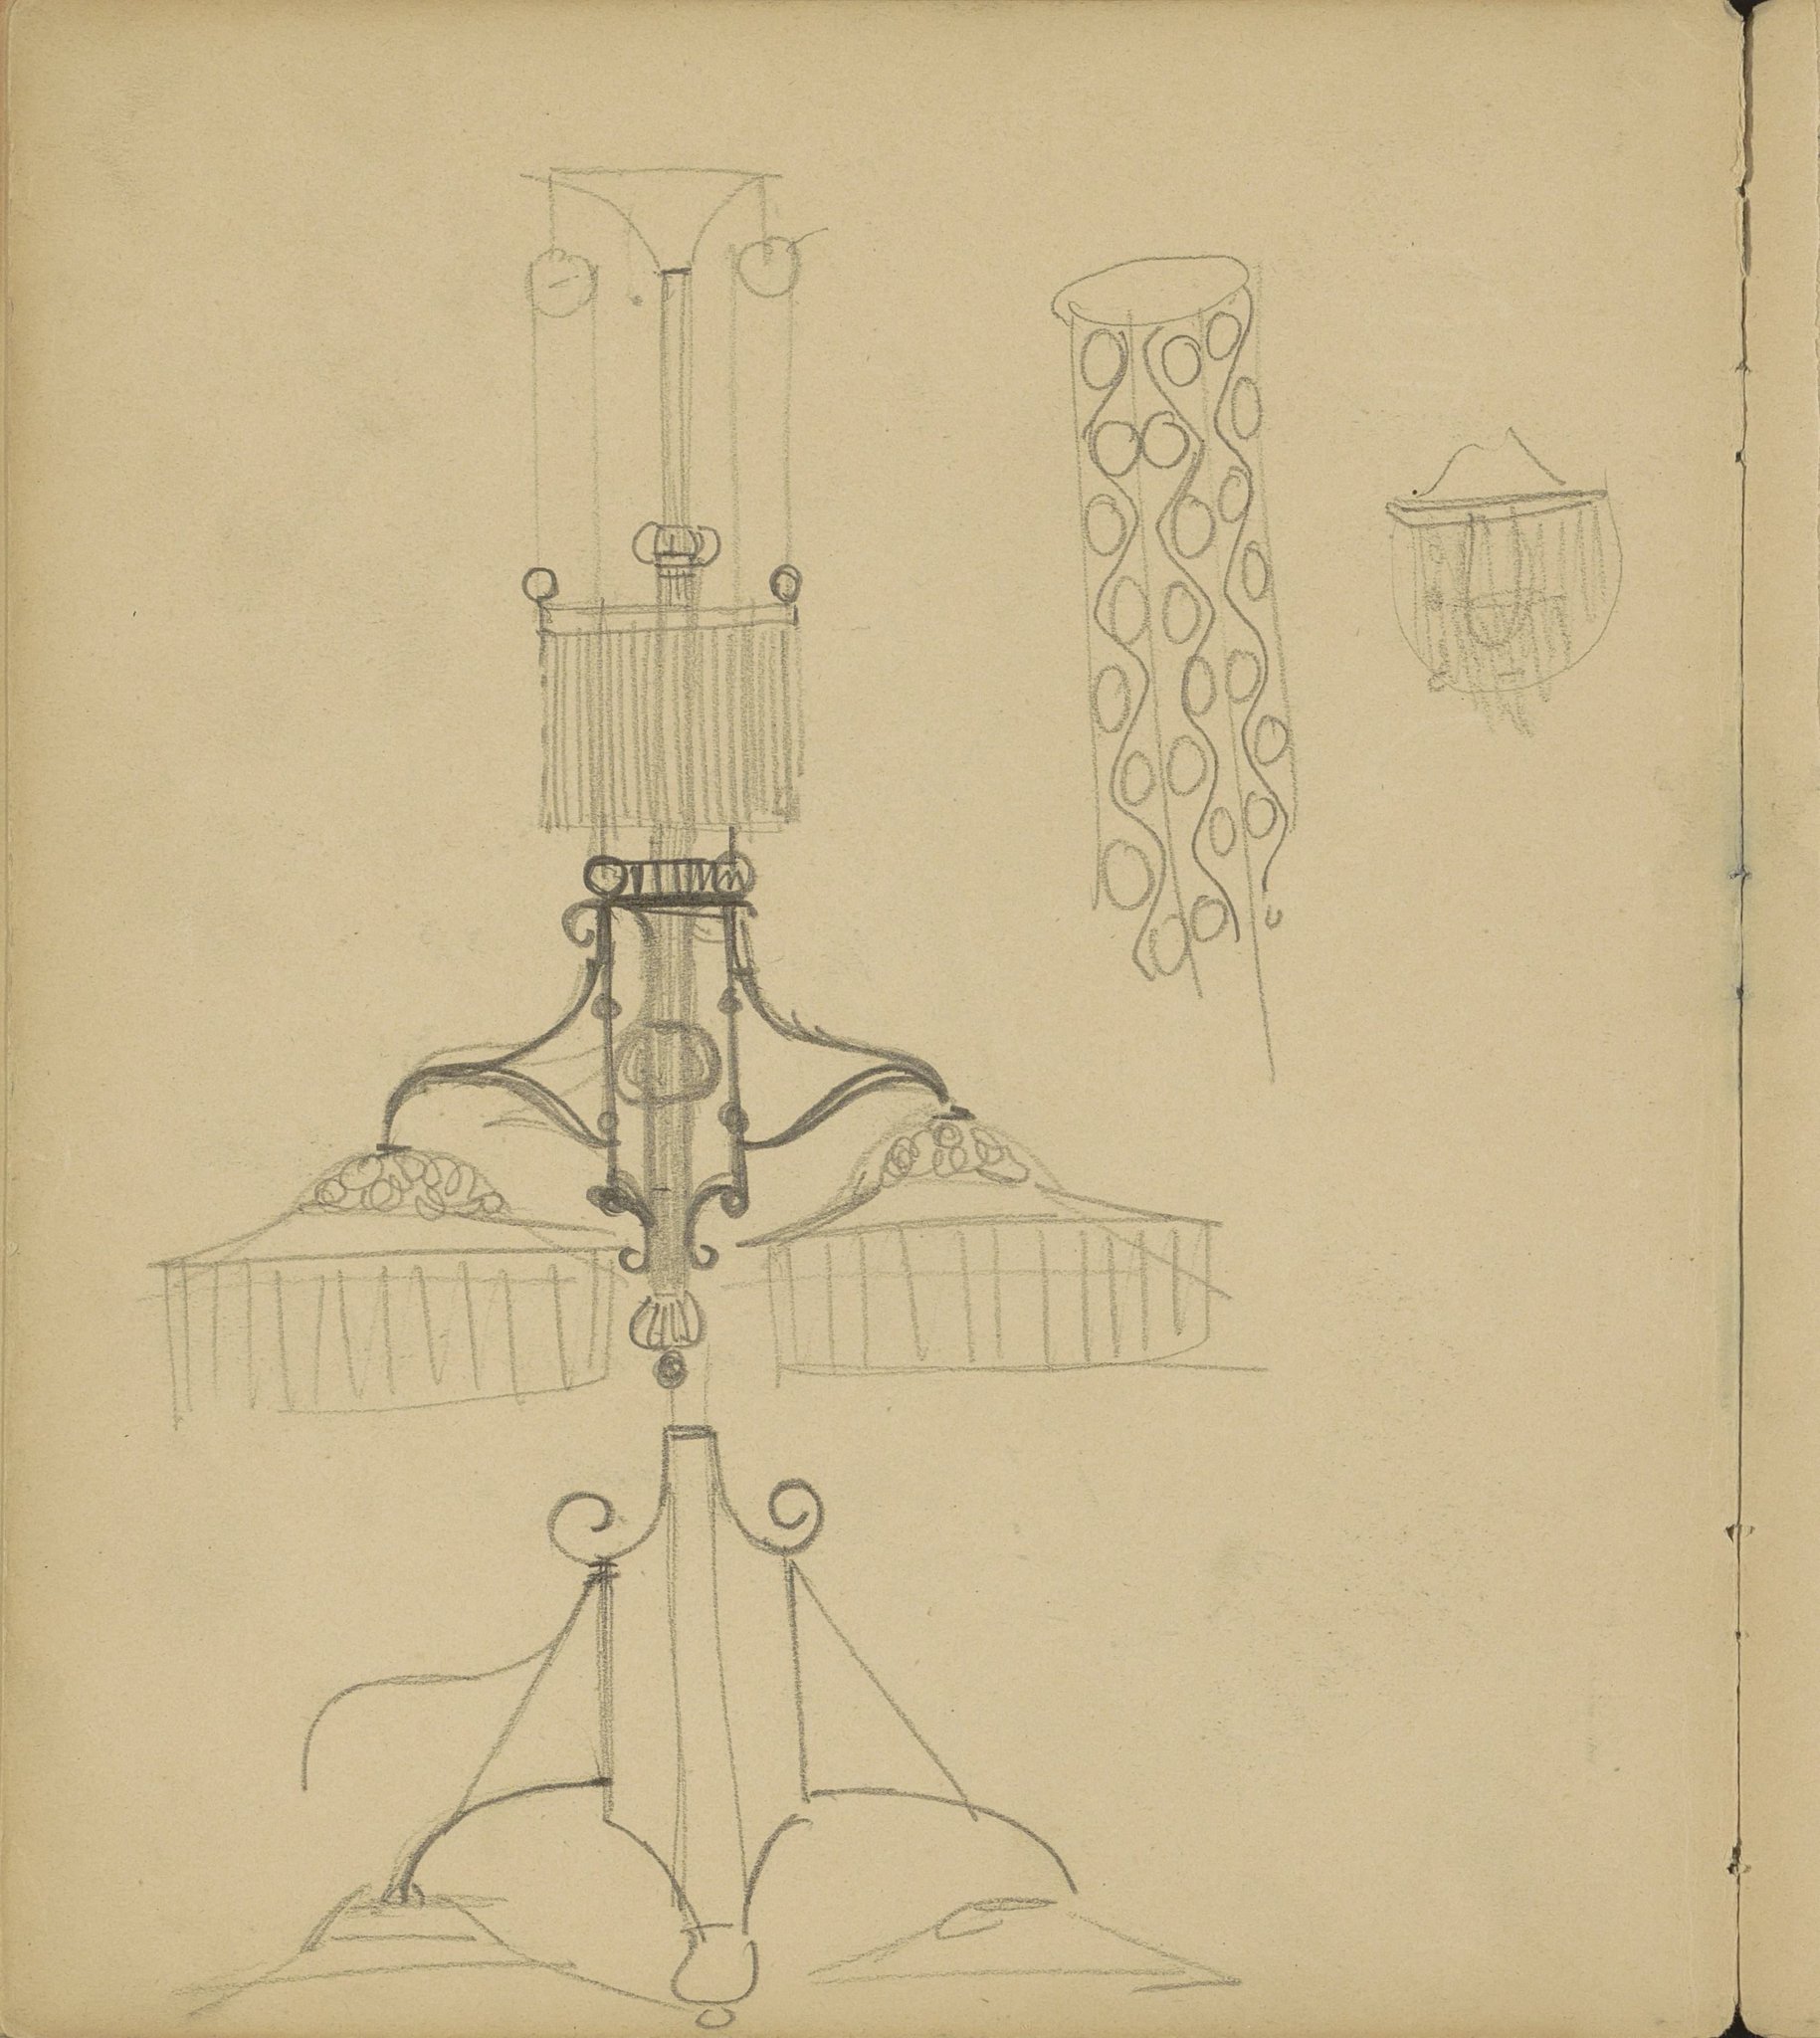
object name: sketchbook leaf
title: Ontwerpen voor lampen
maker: carel adolph lion cachet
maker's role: draughtsman, print maker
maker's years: 1864-1945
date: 1906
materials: paper, pencil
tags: lighting; lamps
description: Blad 26 verso uit een schetsboek met 27 bladen.